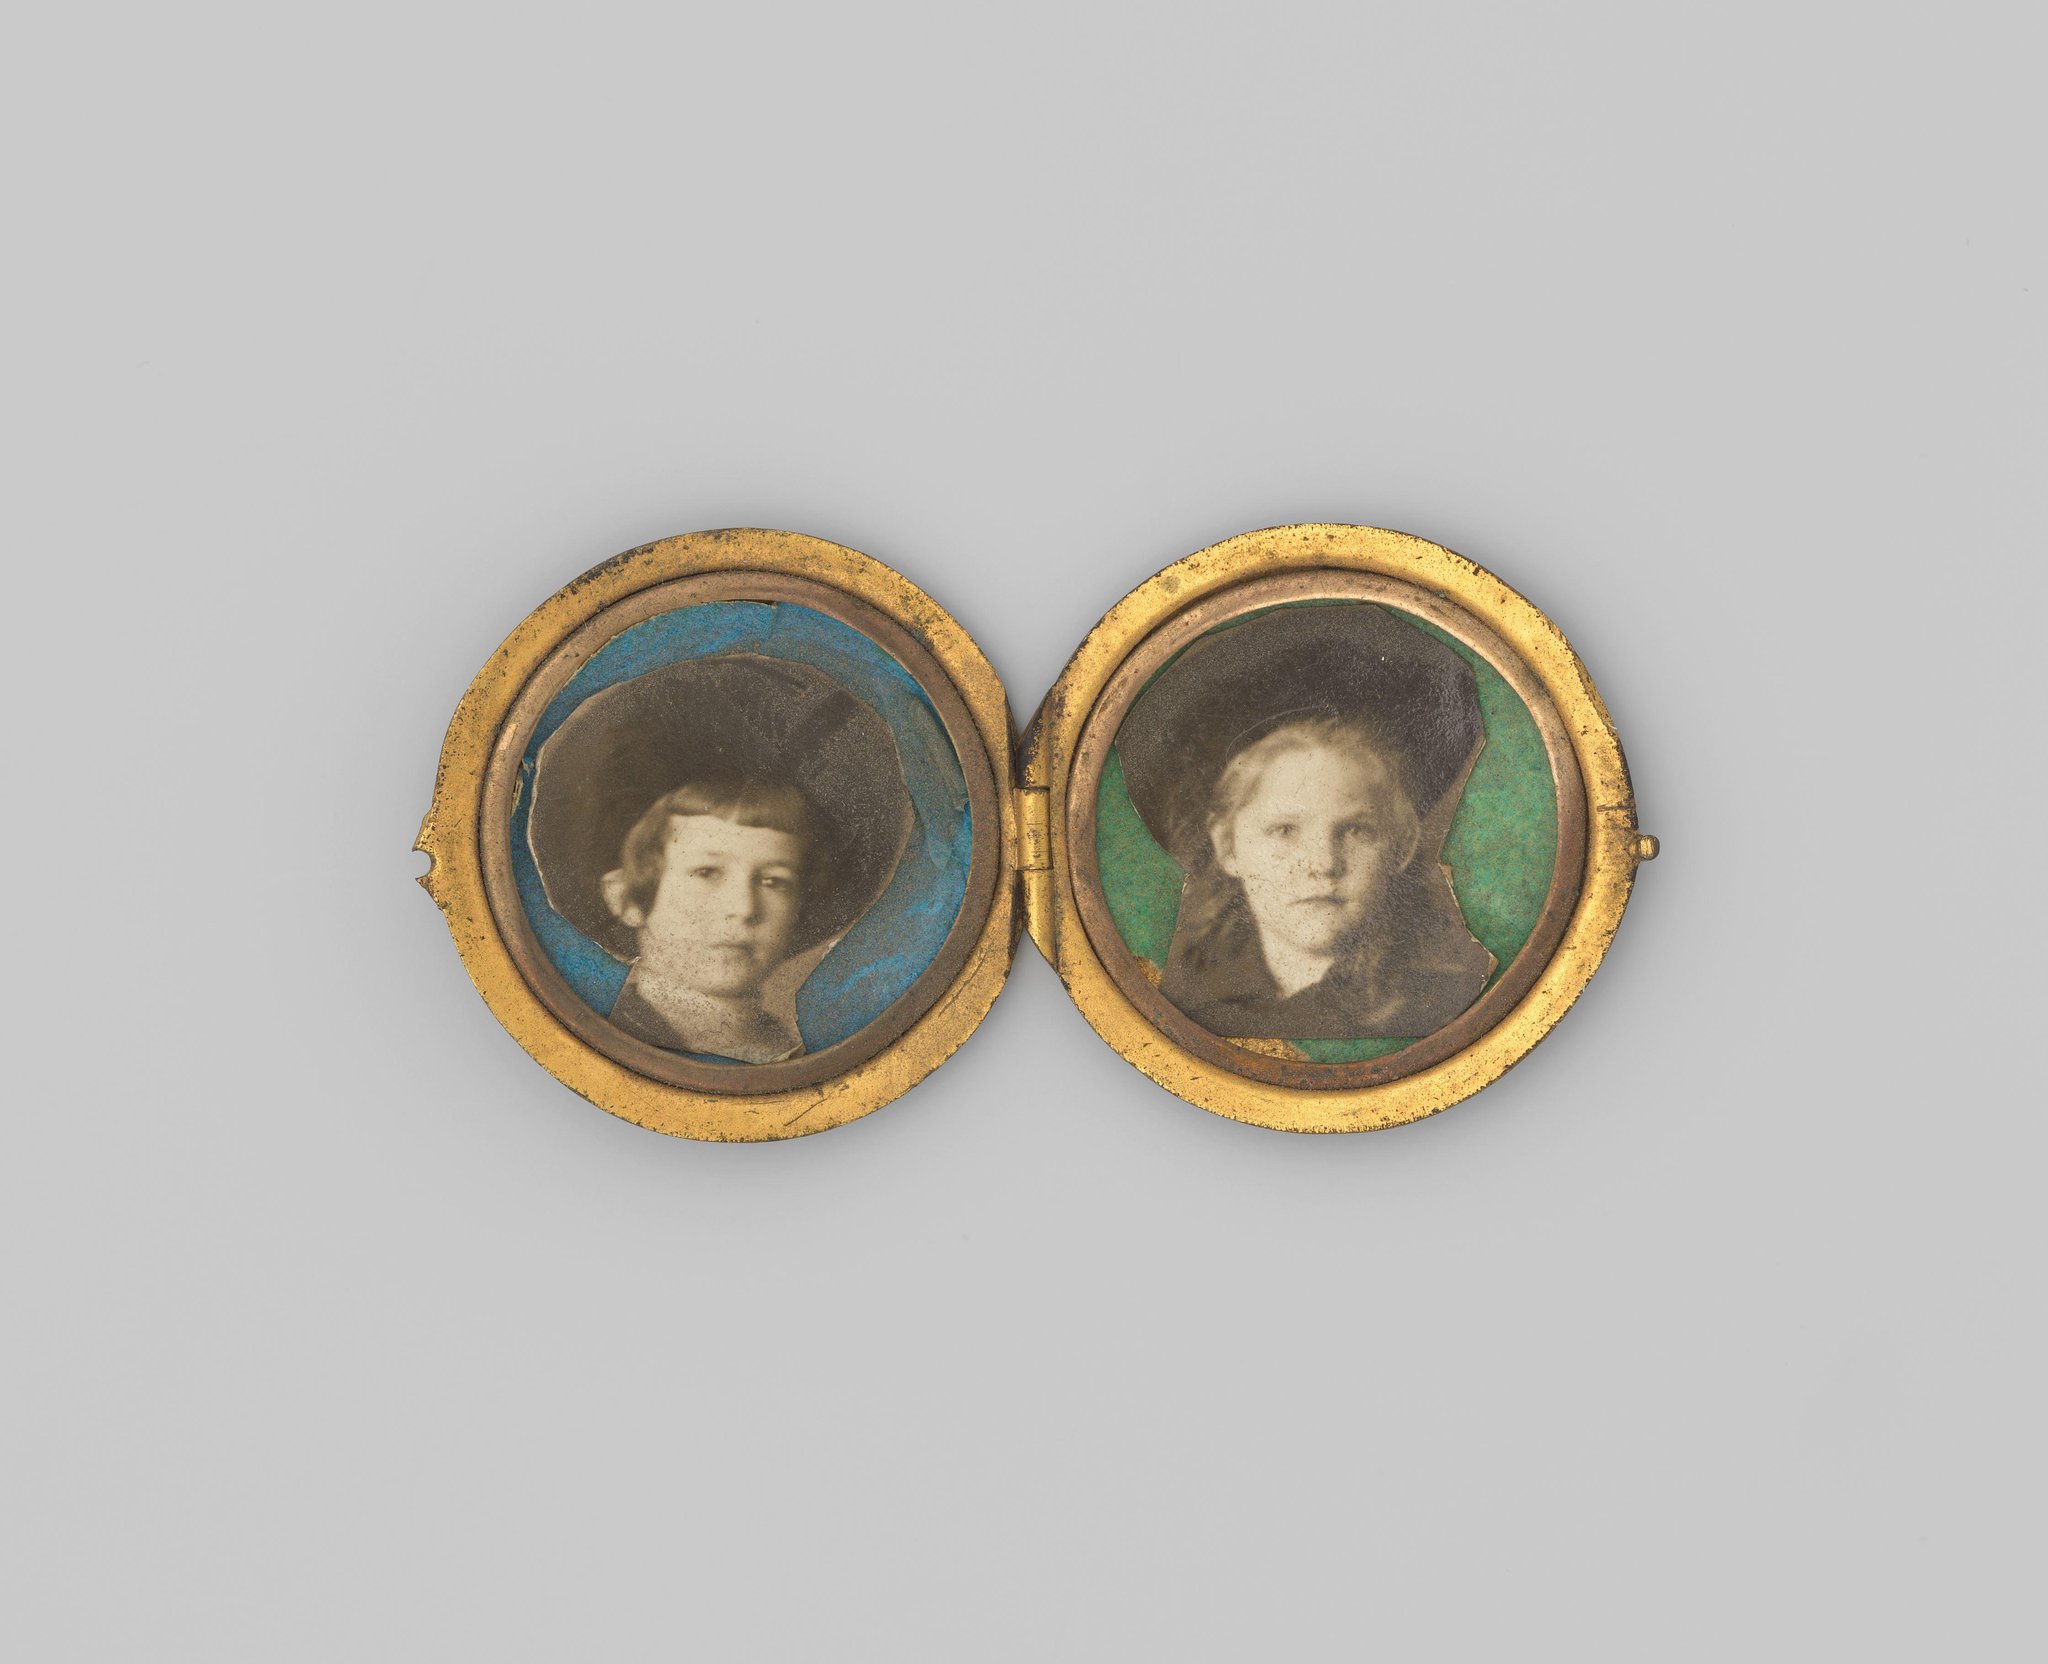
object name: photograph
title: Portret van een onbekend meisje met hoed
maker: Anonymous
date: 1880-1910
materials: paper, watercolor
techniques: brush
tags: historical persons, girl (child between toddler and youth)